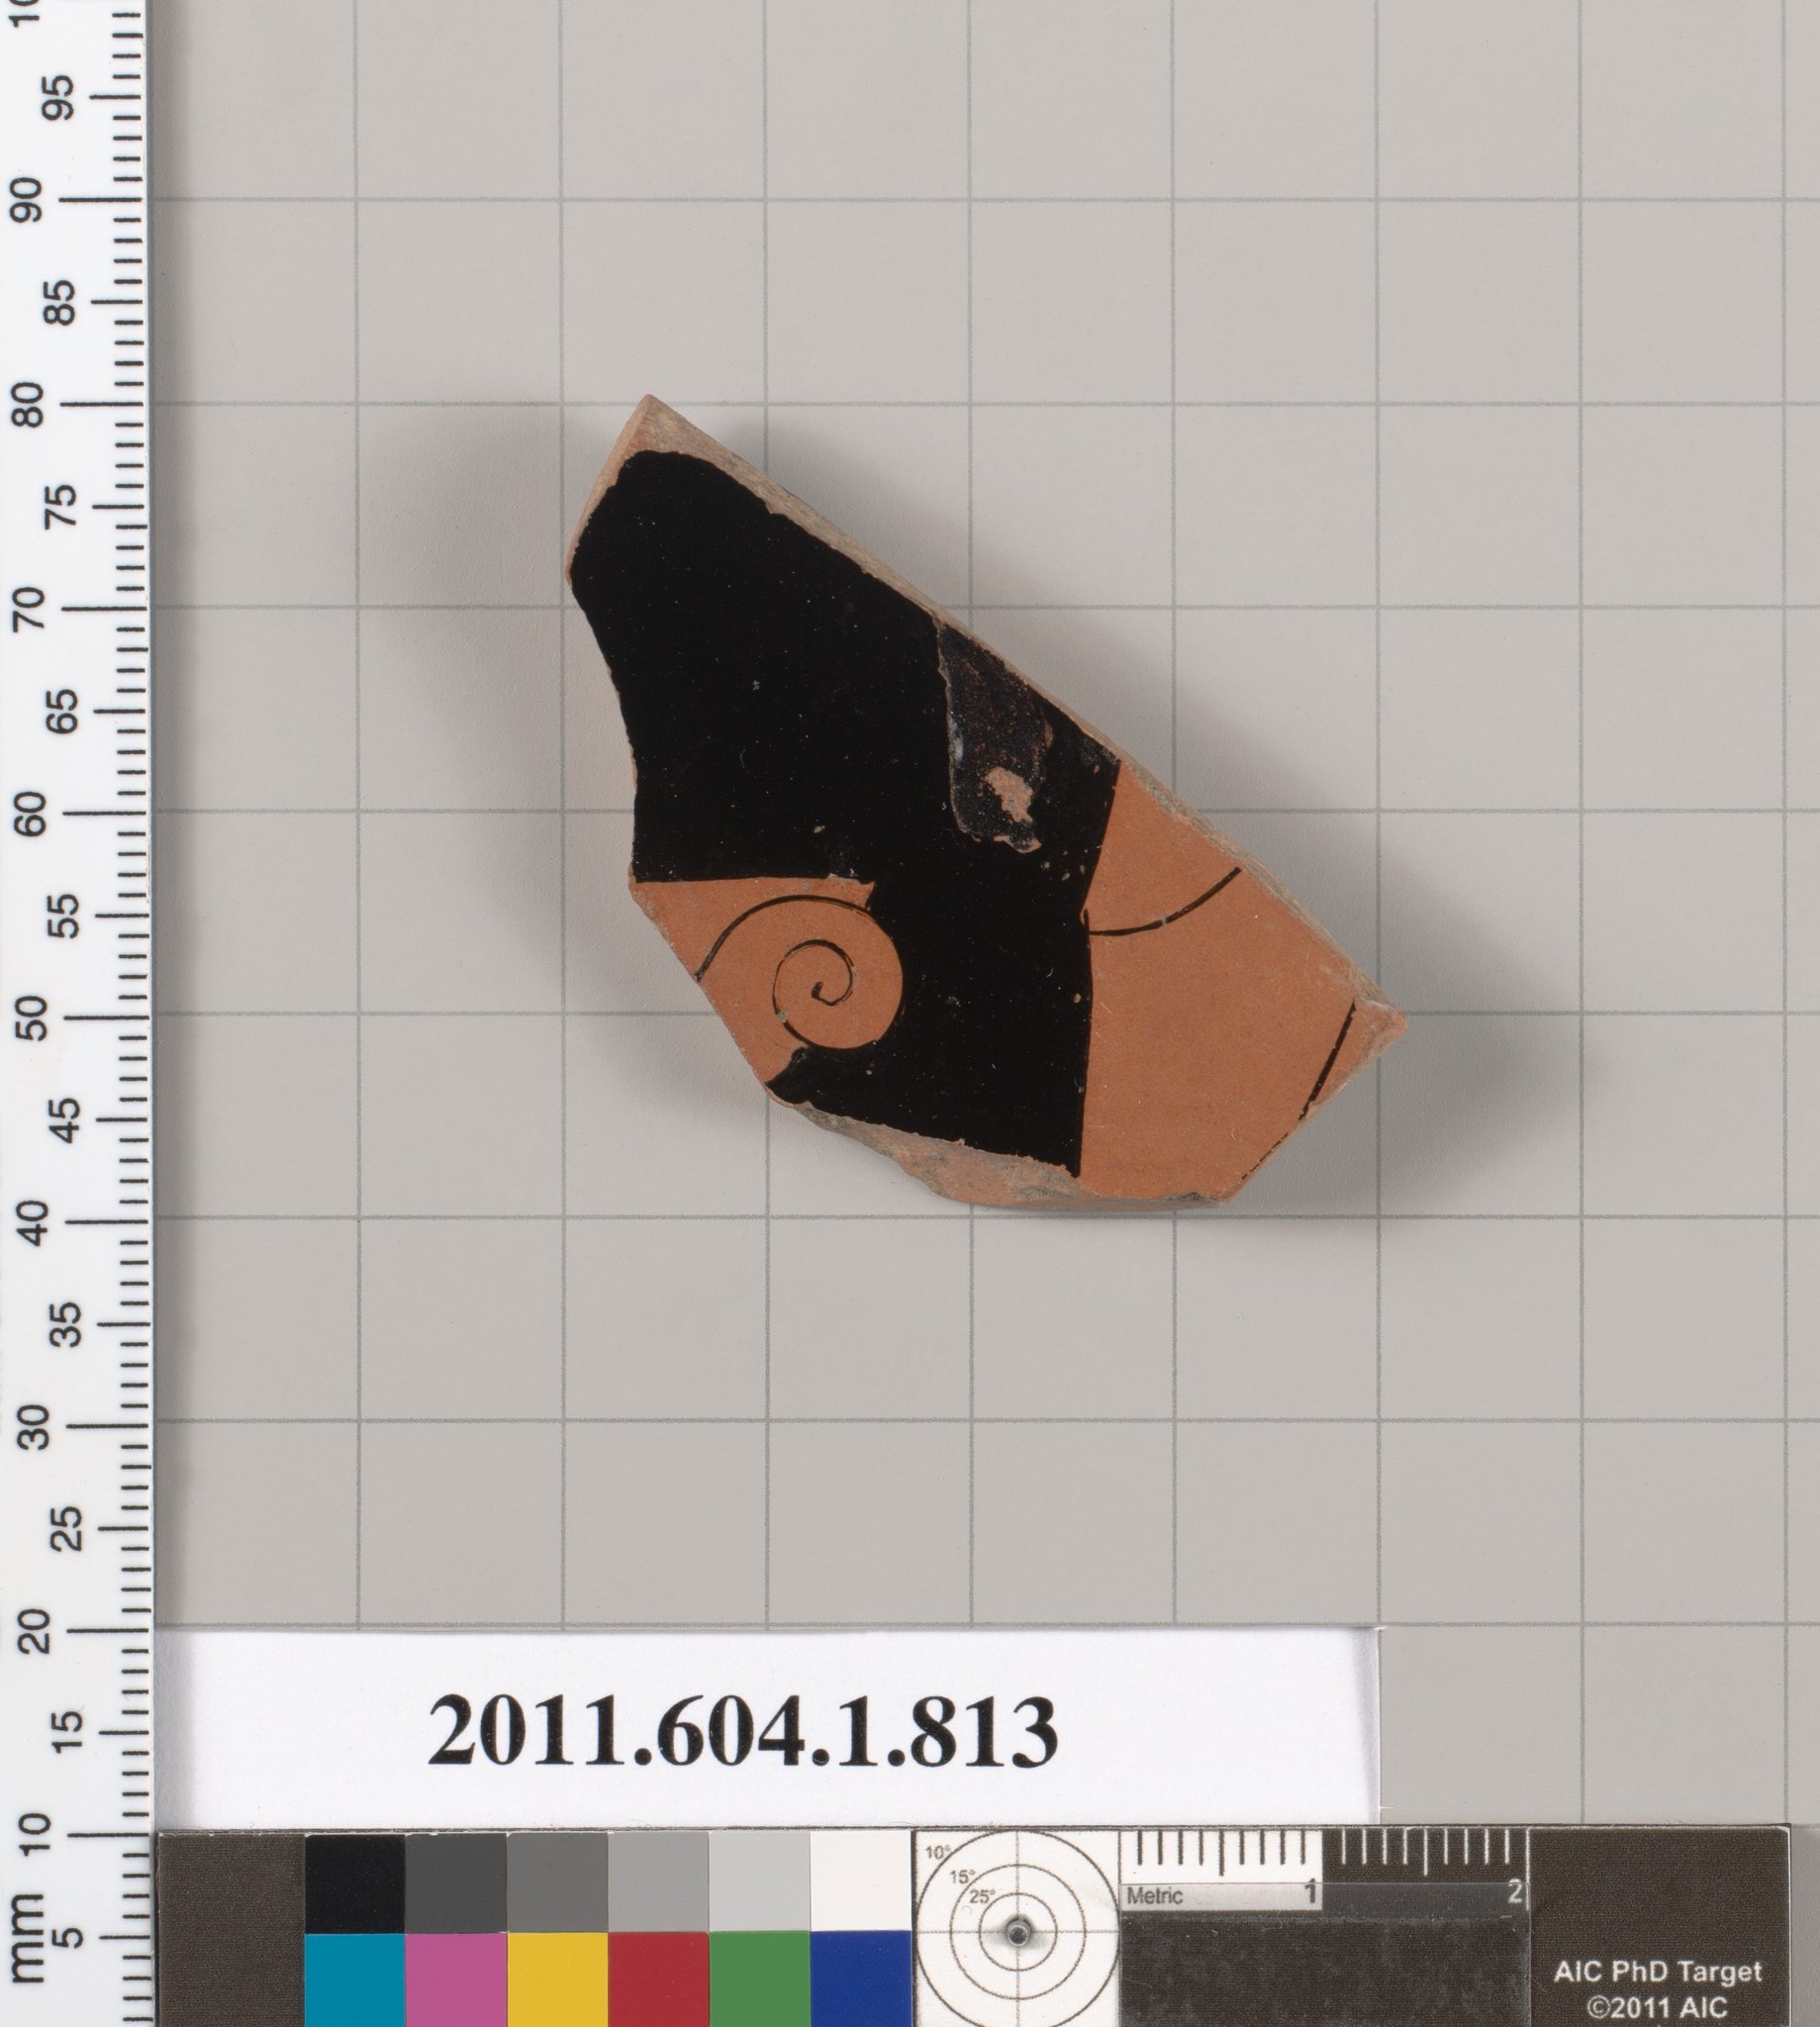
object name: kylix fragment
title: Terracotta fragment of a kylix (drinking cup)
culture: greek, attic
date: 475-451 BCE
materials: terracotta